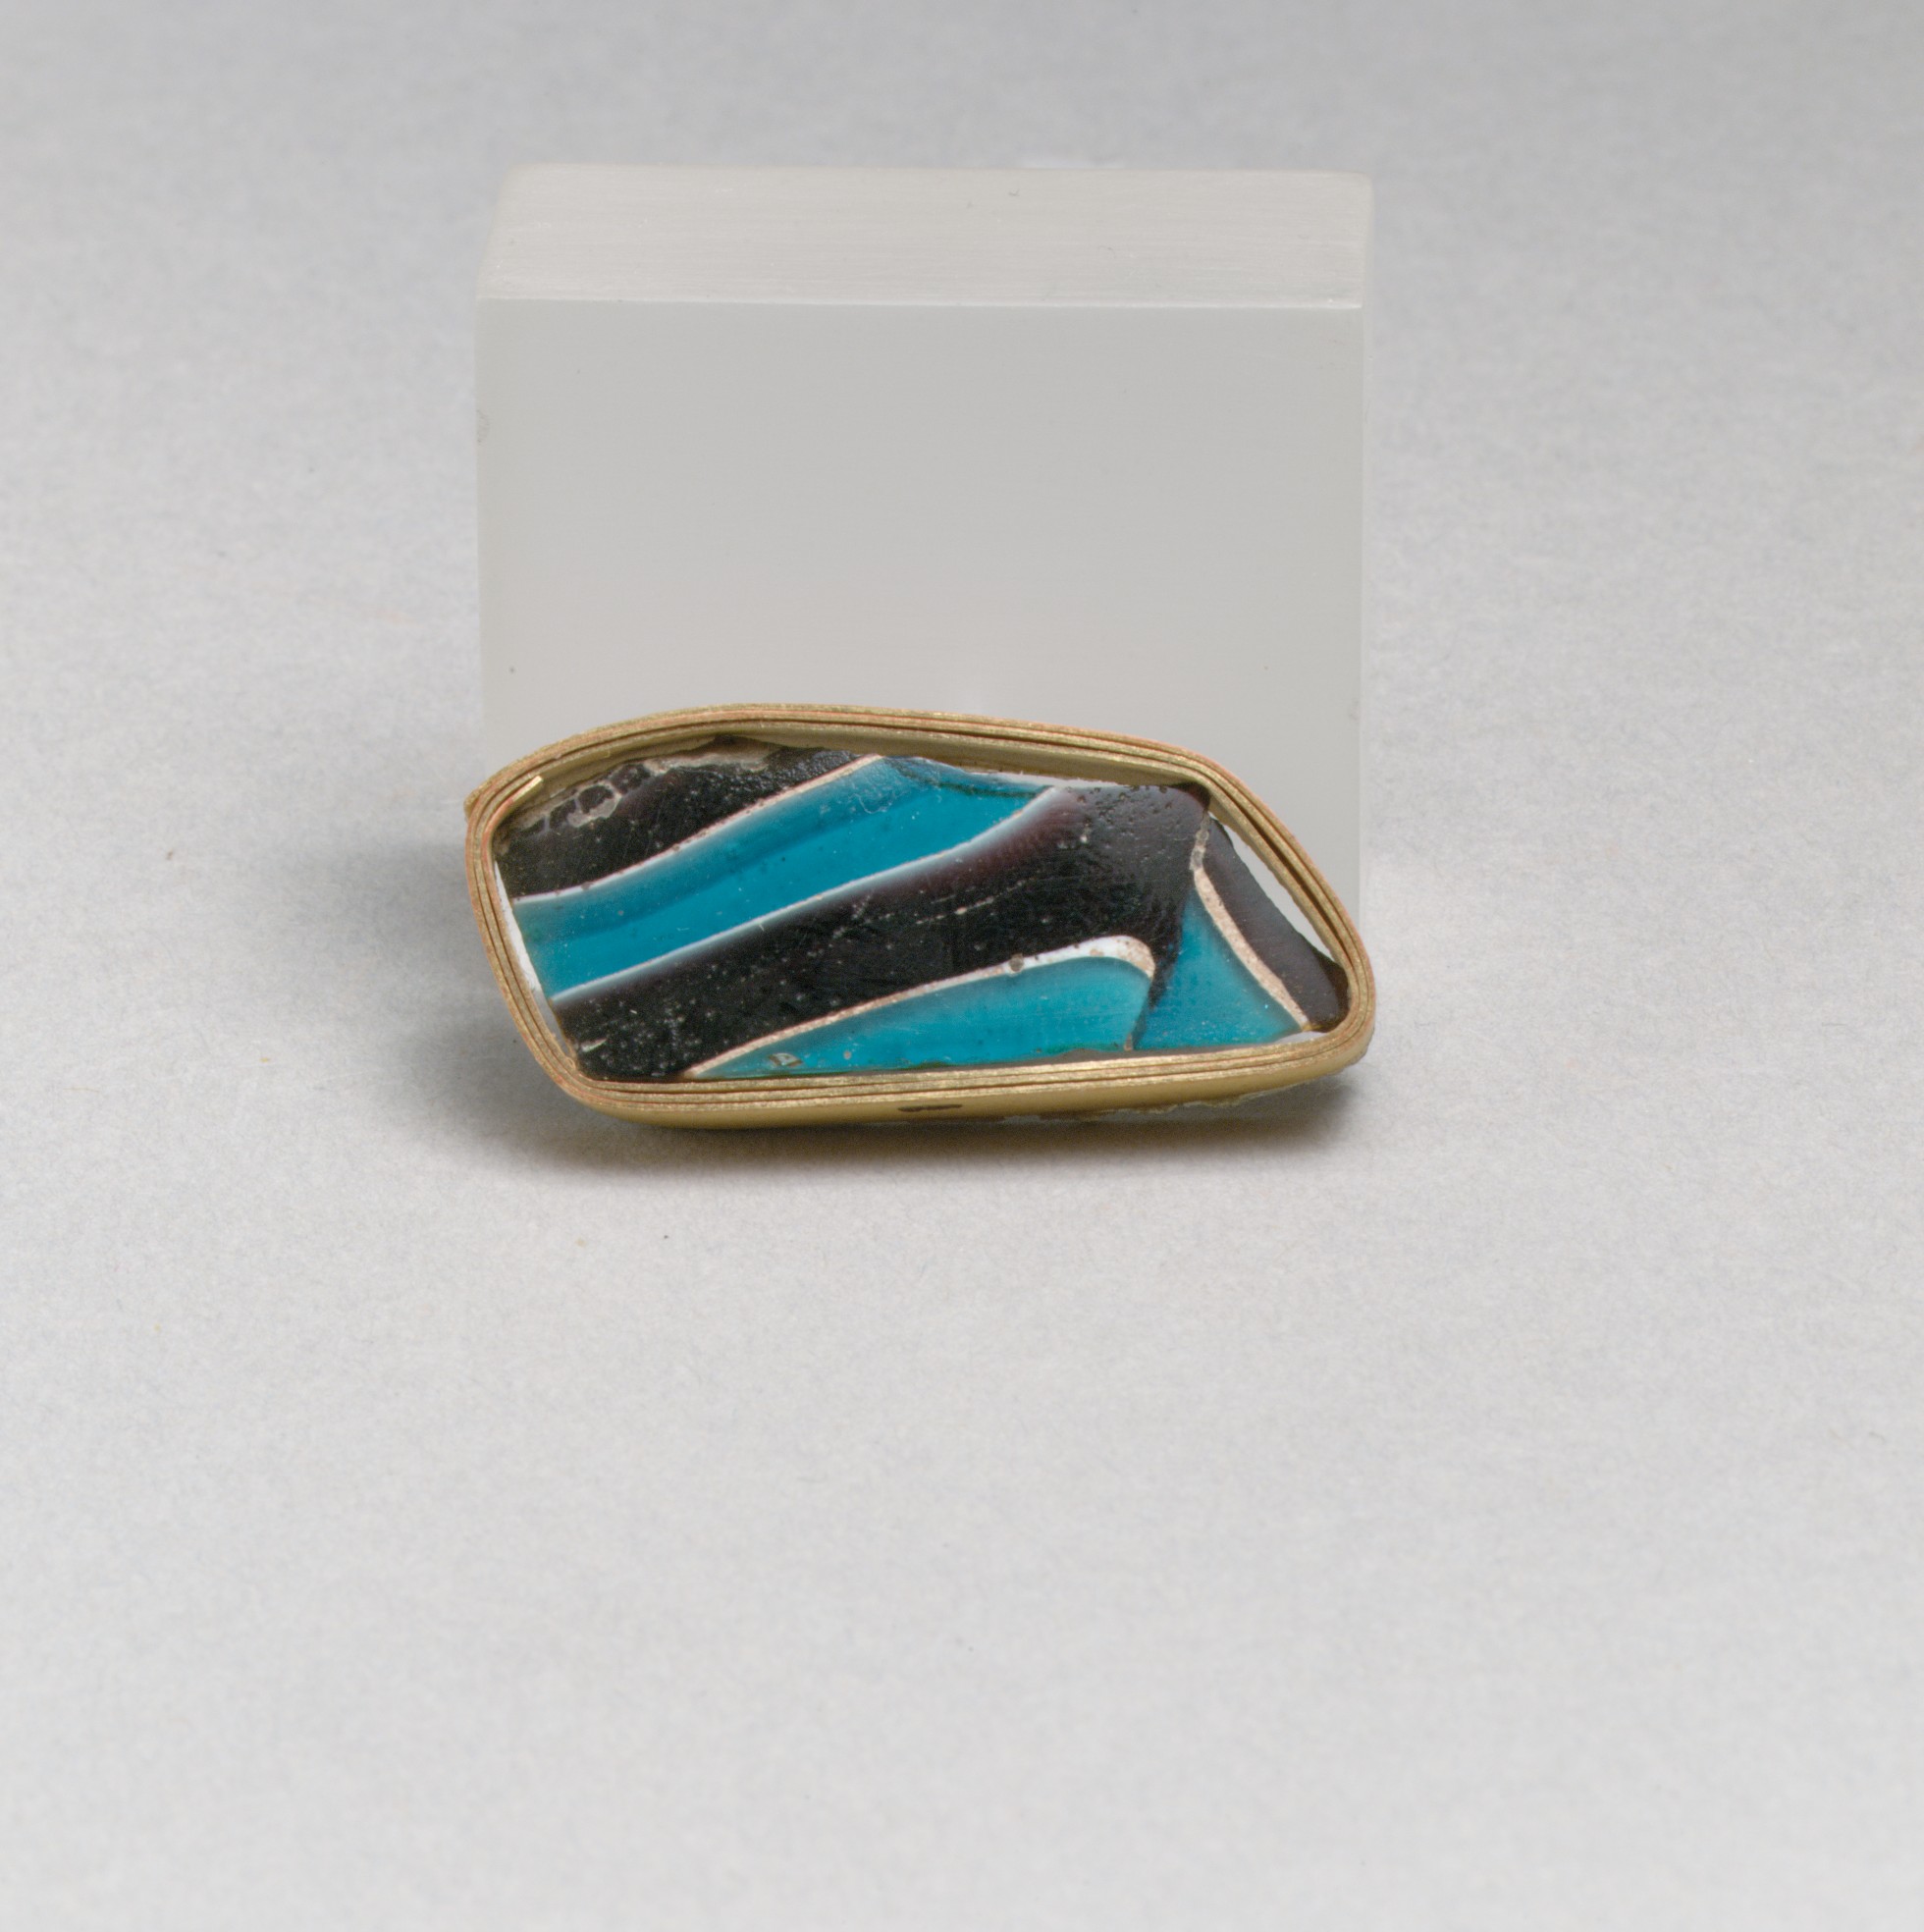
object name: fragment, mosaic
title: Glass mosaic fragment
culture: roman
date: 34 BCE-33 CE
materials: glass